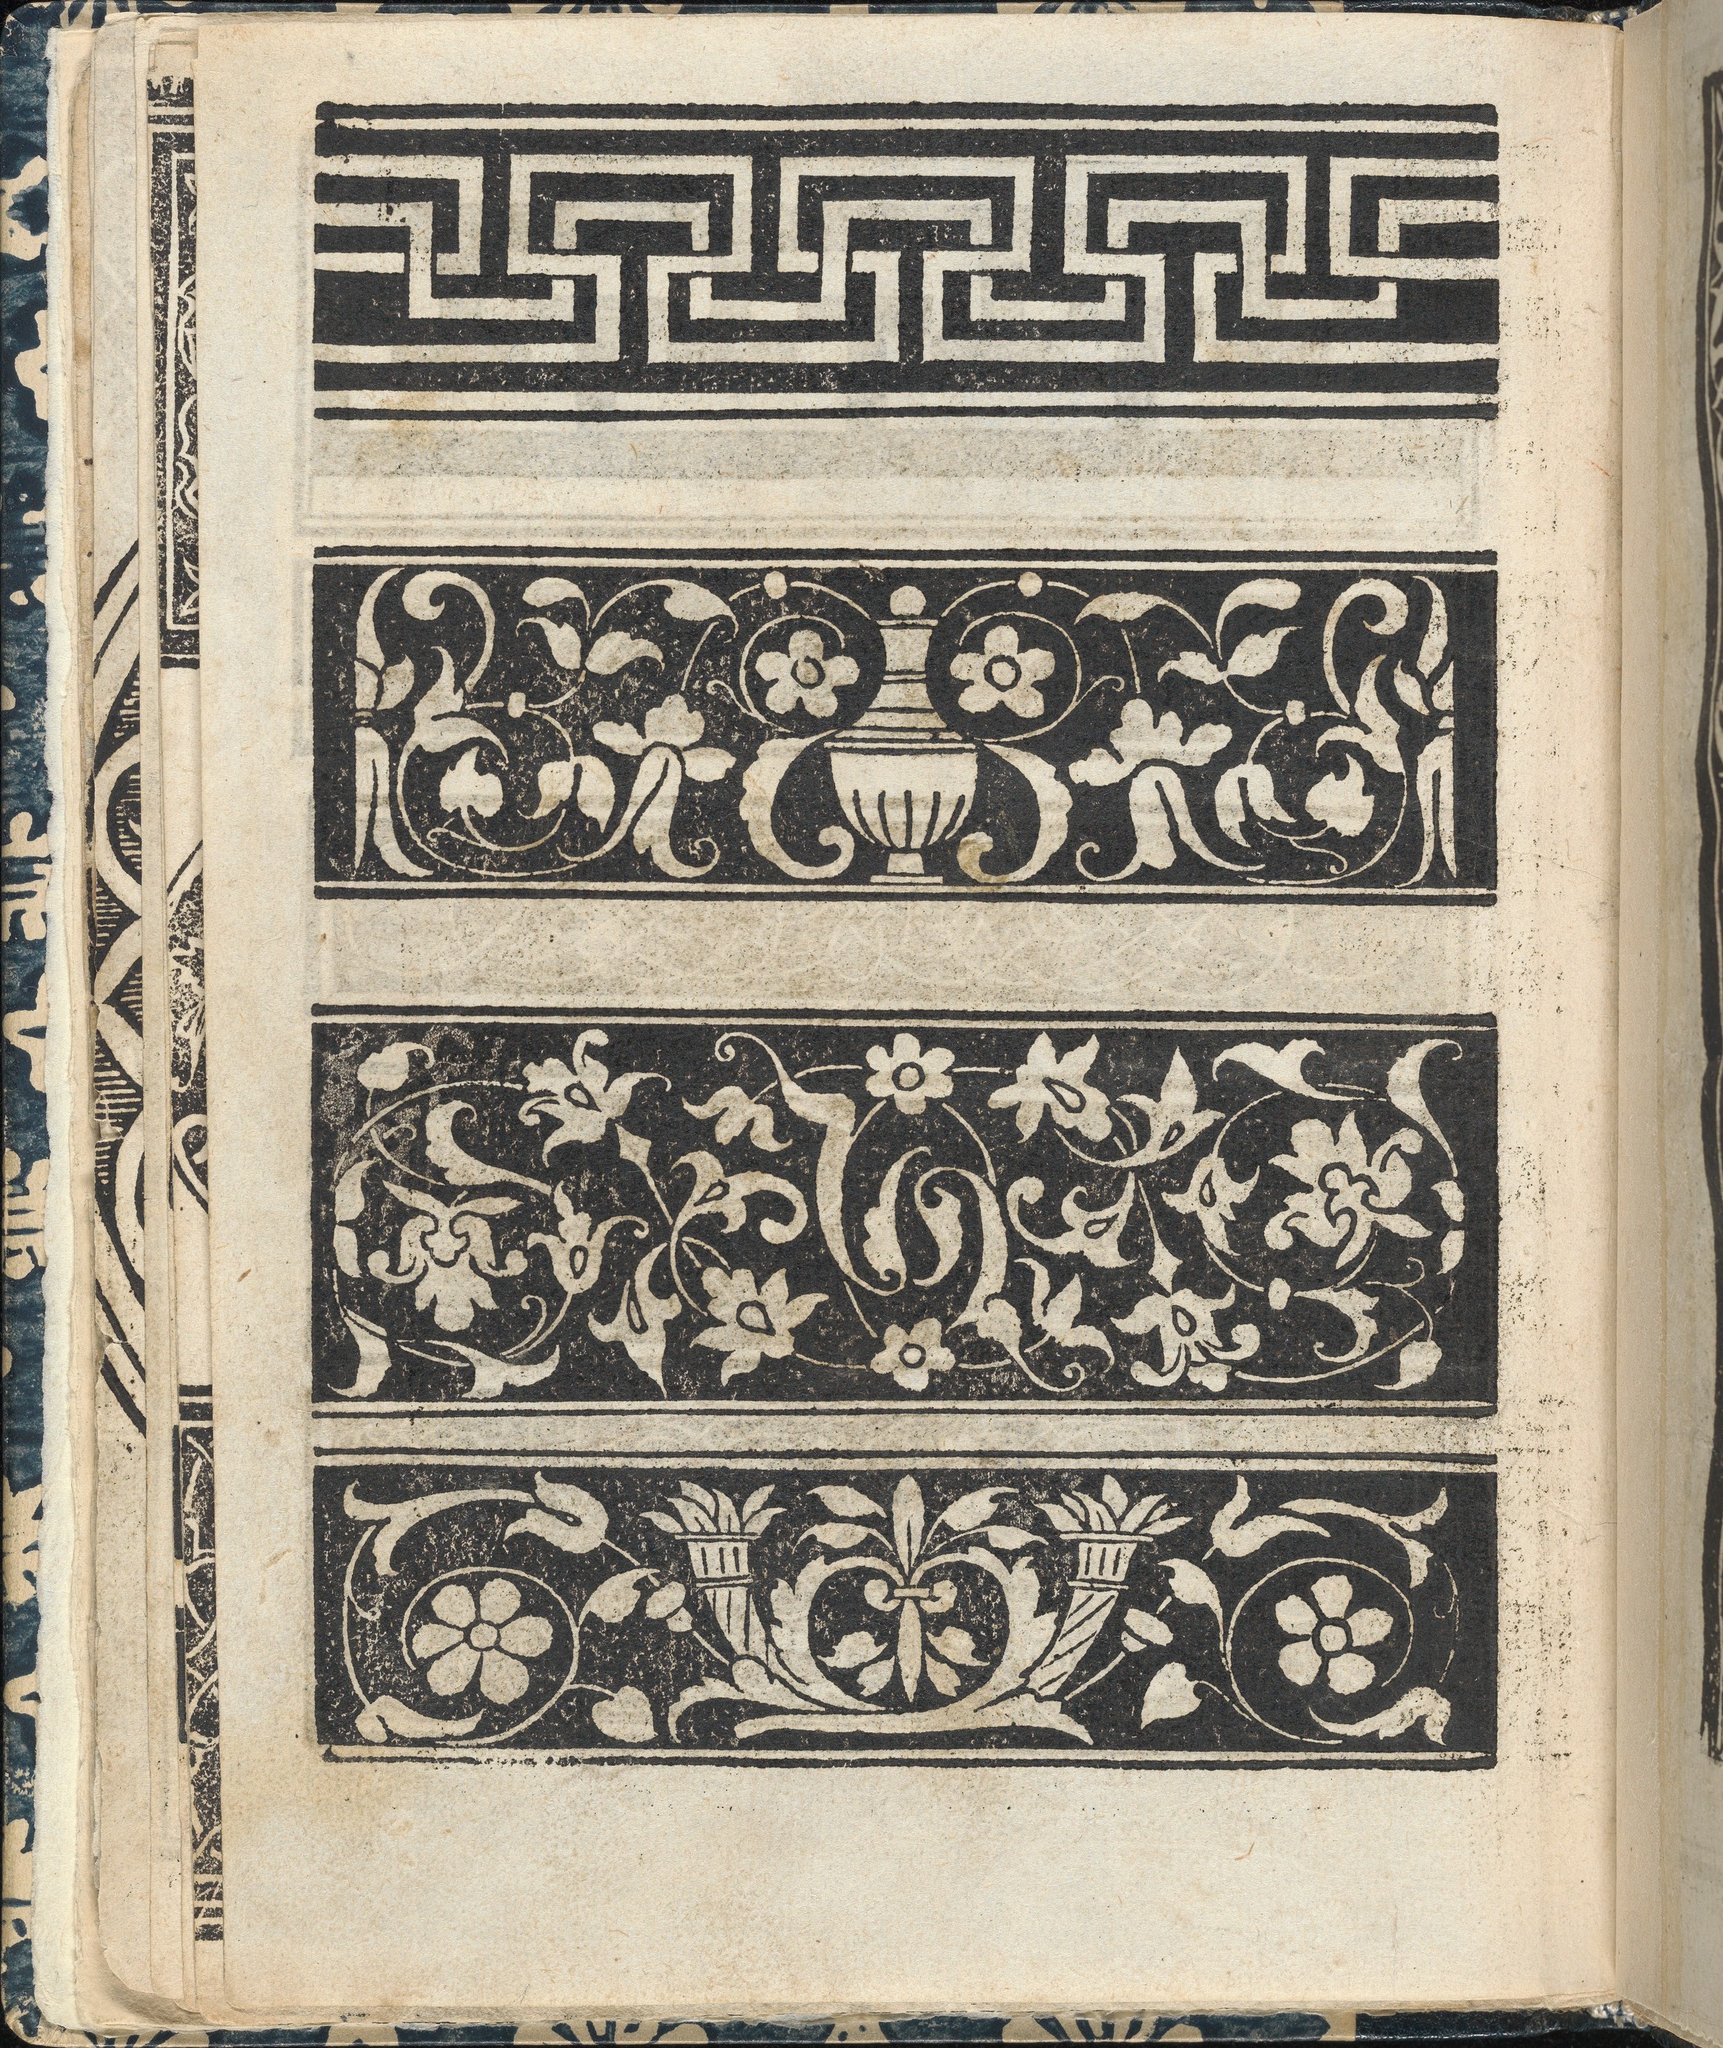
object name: book print ornament architecture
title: Essempio di recammi, page 22 (verso)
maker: giovanni antonio tagliente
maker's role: author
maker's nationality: italian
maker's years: 1465-1528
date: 1530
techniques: woodcut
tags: flowers